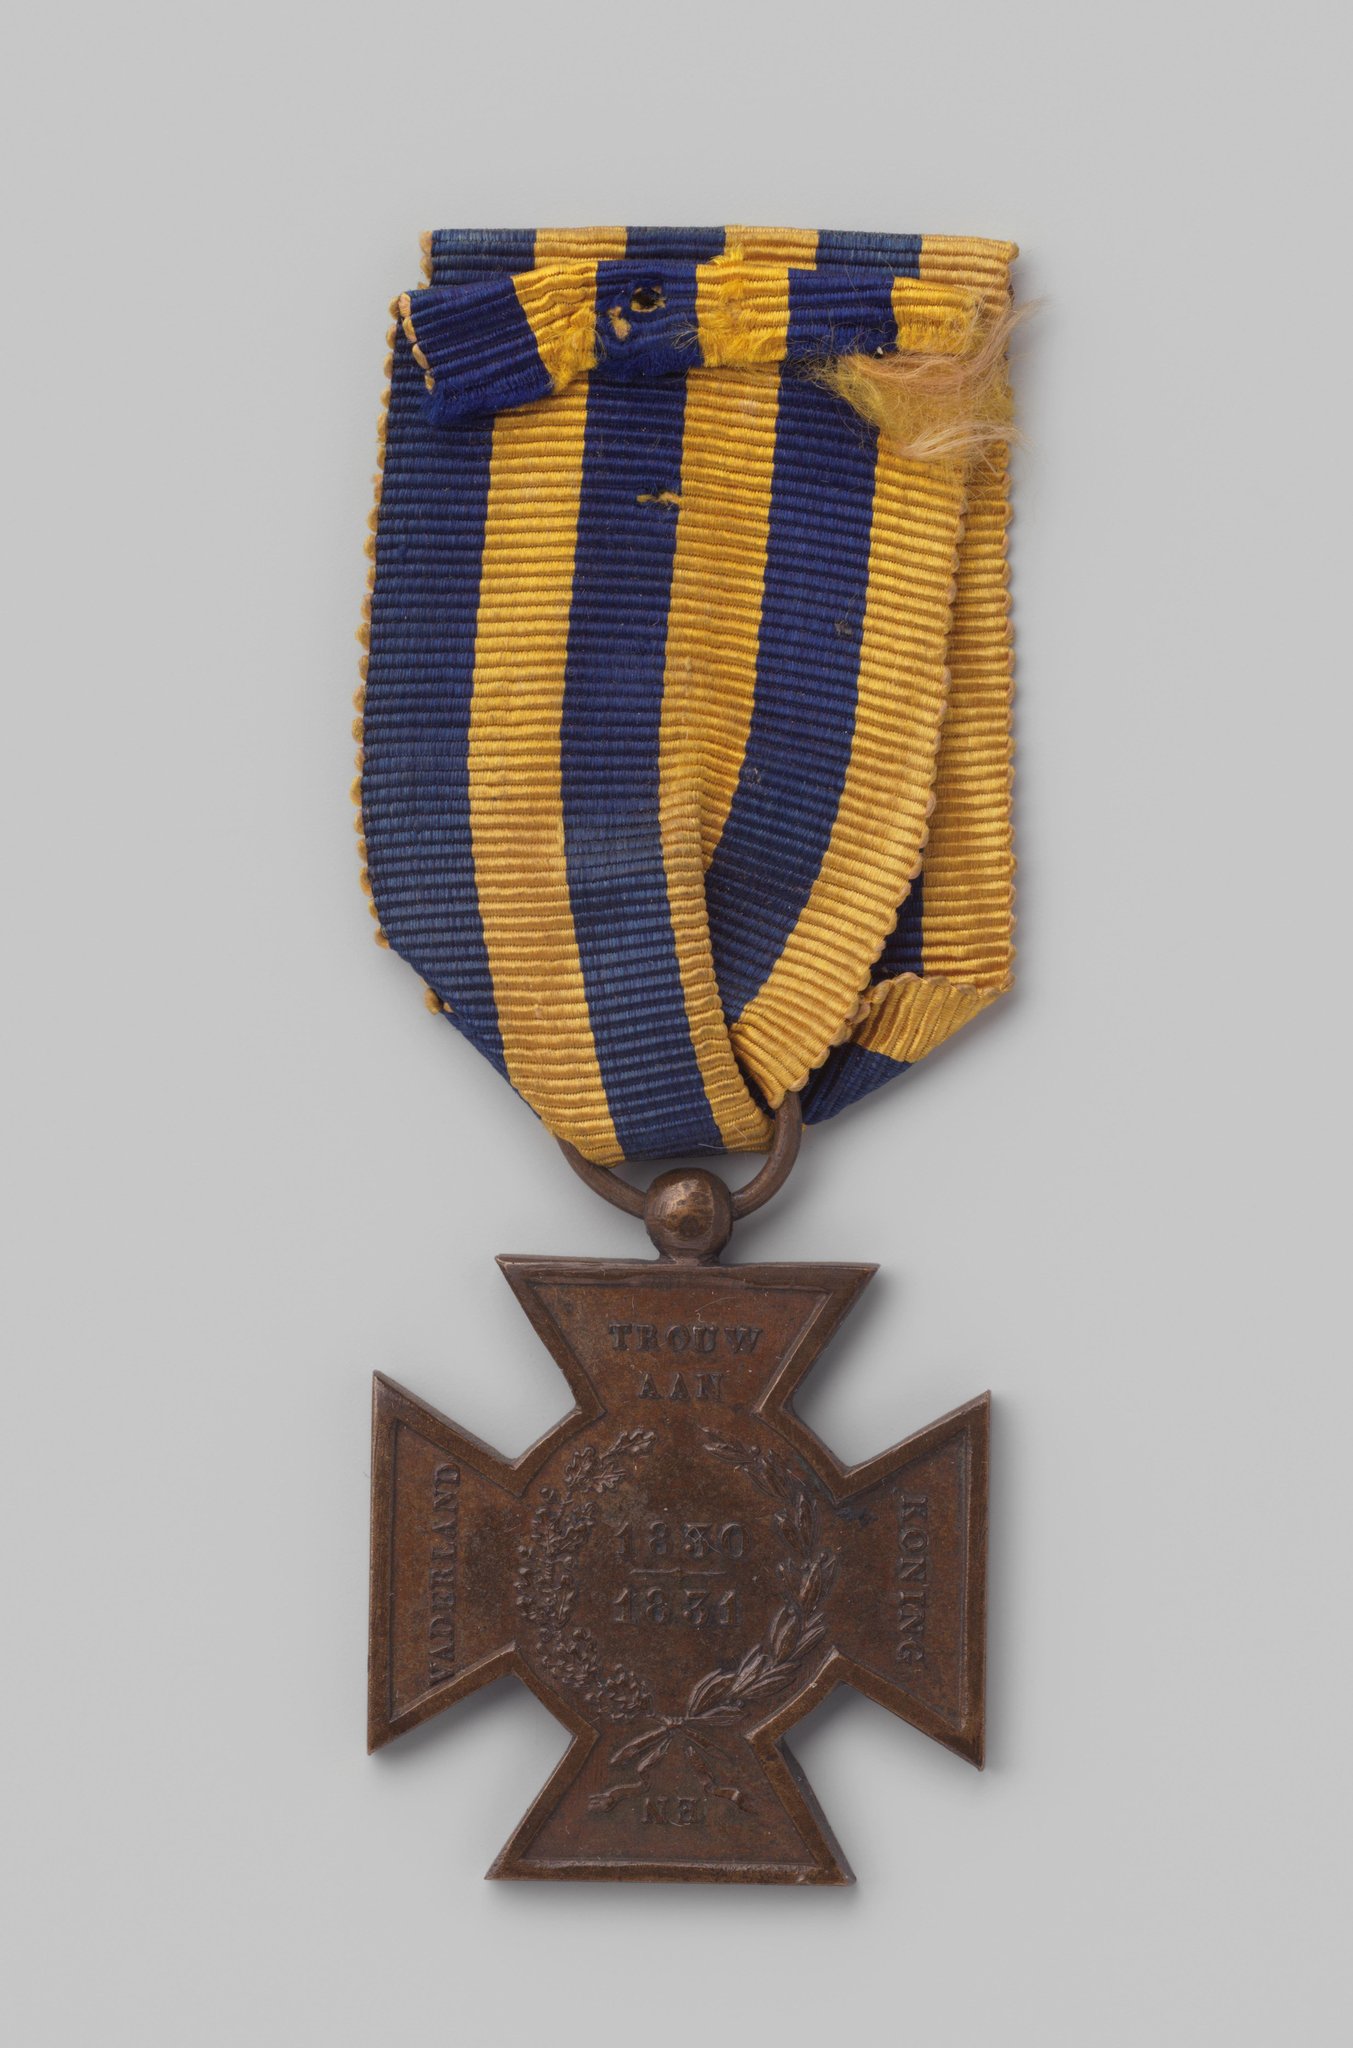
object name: onderscheidingsteken, onderscheiding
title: Metalen Kruis 1830-1831 met blauw-geel lint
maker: Anonymous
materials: bronze, textile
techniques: forging, striking, weave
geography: netherlands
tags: metalen kruis, belgische revolutie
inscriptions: : ‘TROUW AAN/ KONING/ EN/ VADERLAND’, : ‘gekroonde W’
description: Metalen kruis 1830-1831 met vier bronzen armen. Aan de voorzijde een gekroonde W omgeven door aan de linkerzijde eikenbladeren en aan de rechterzijde laurierbladeren welke elkaar onder de gekroonde W overlappen. Aan de achterzijde van het kruis een tekst op iedere arm, aan de bovenzijde TROUW AAN, rechterzijde KONING, onderzijde EN, en aan de linkerzijde VADERLAND. Centraal staat het jaartal 1830-1831. Aan de bovenzijde een ring waaraan het driemaal verticaal gestreepte blauw-geel lint bevestigd is.